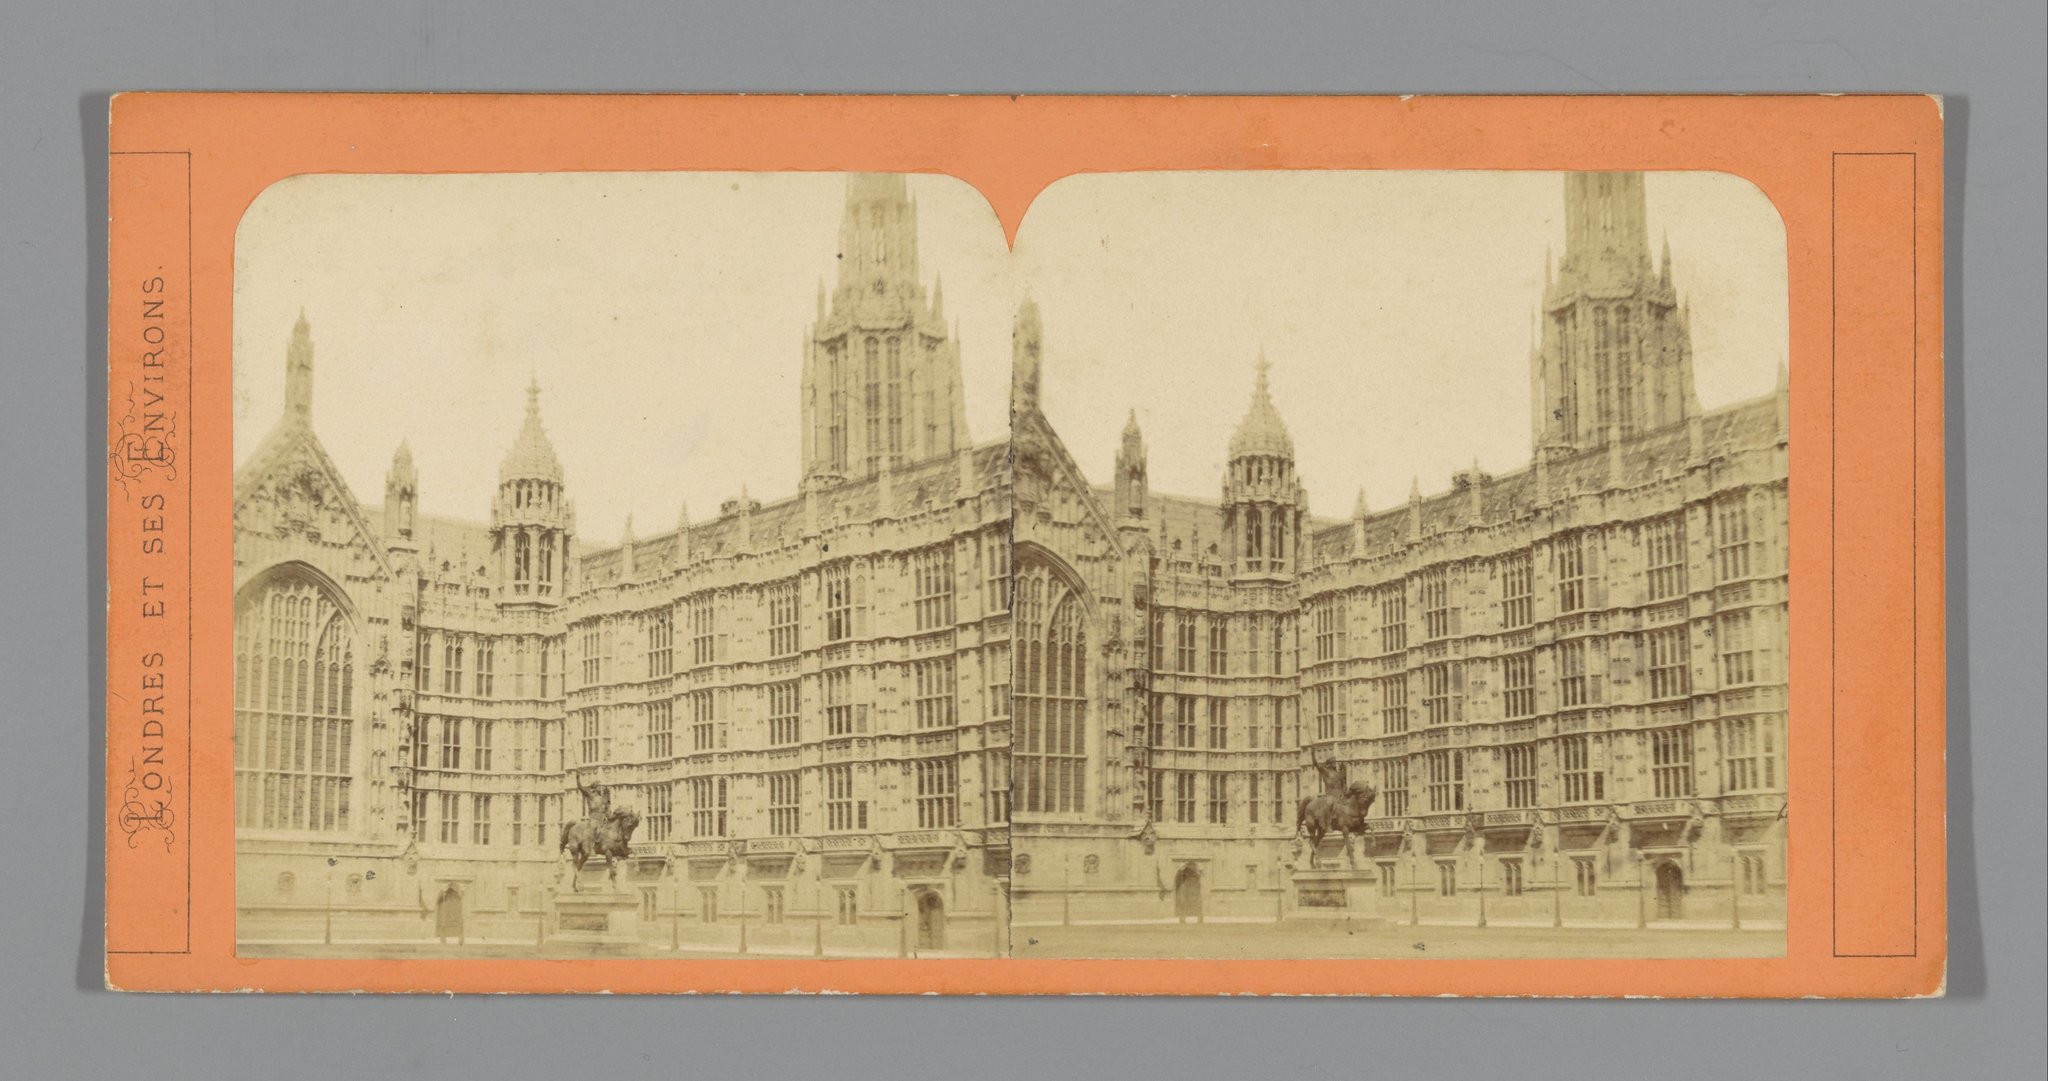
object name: stereograph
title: Palace of Westminster met een standbeeld van Richard I van Engeland in Londen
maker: Anonymous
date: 1850-1880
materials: cardboard, photographic support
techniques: albumen print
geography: london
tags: equestrian statue, lower house, parliament, chamber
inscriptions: inscription: ‘Parlement, cote de Westminster’